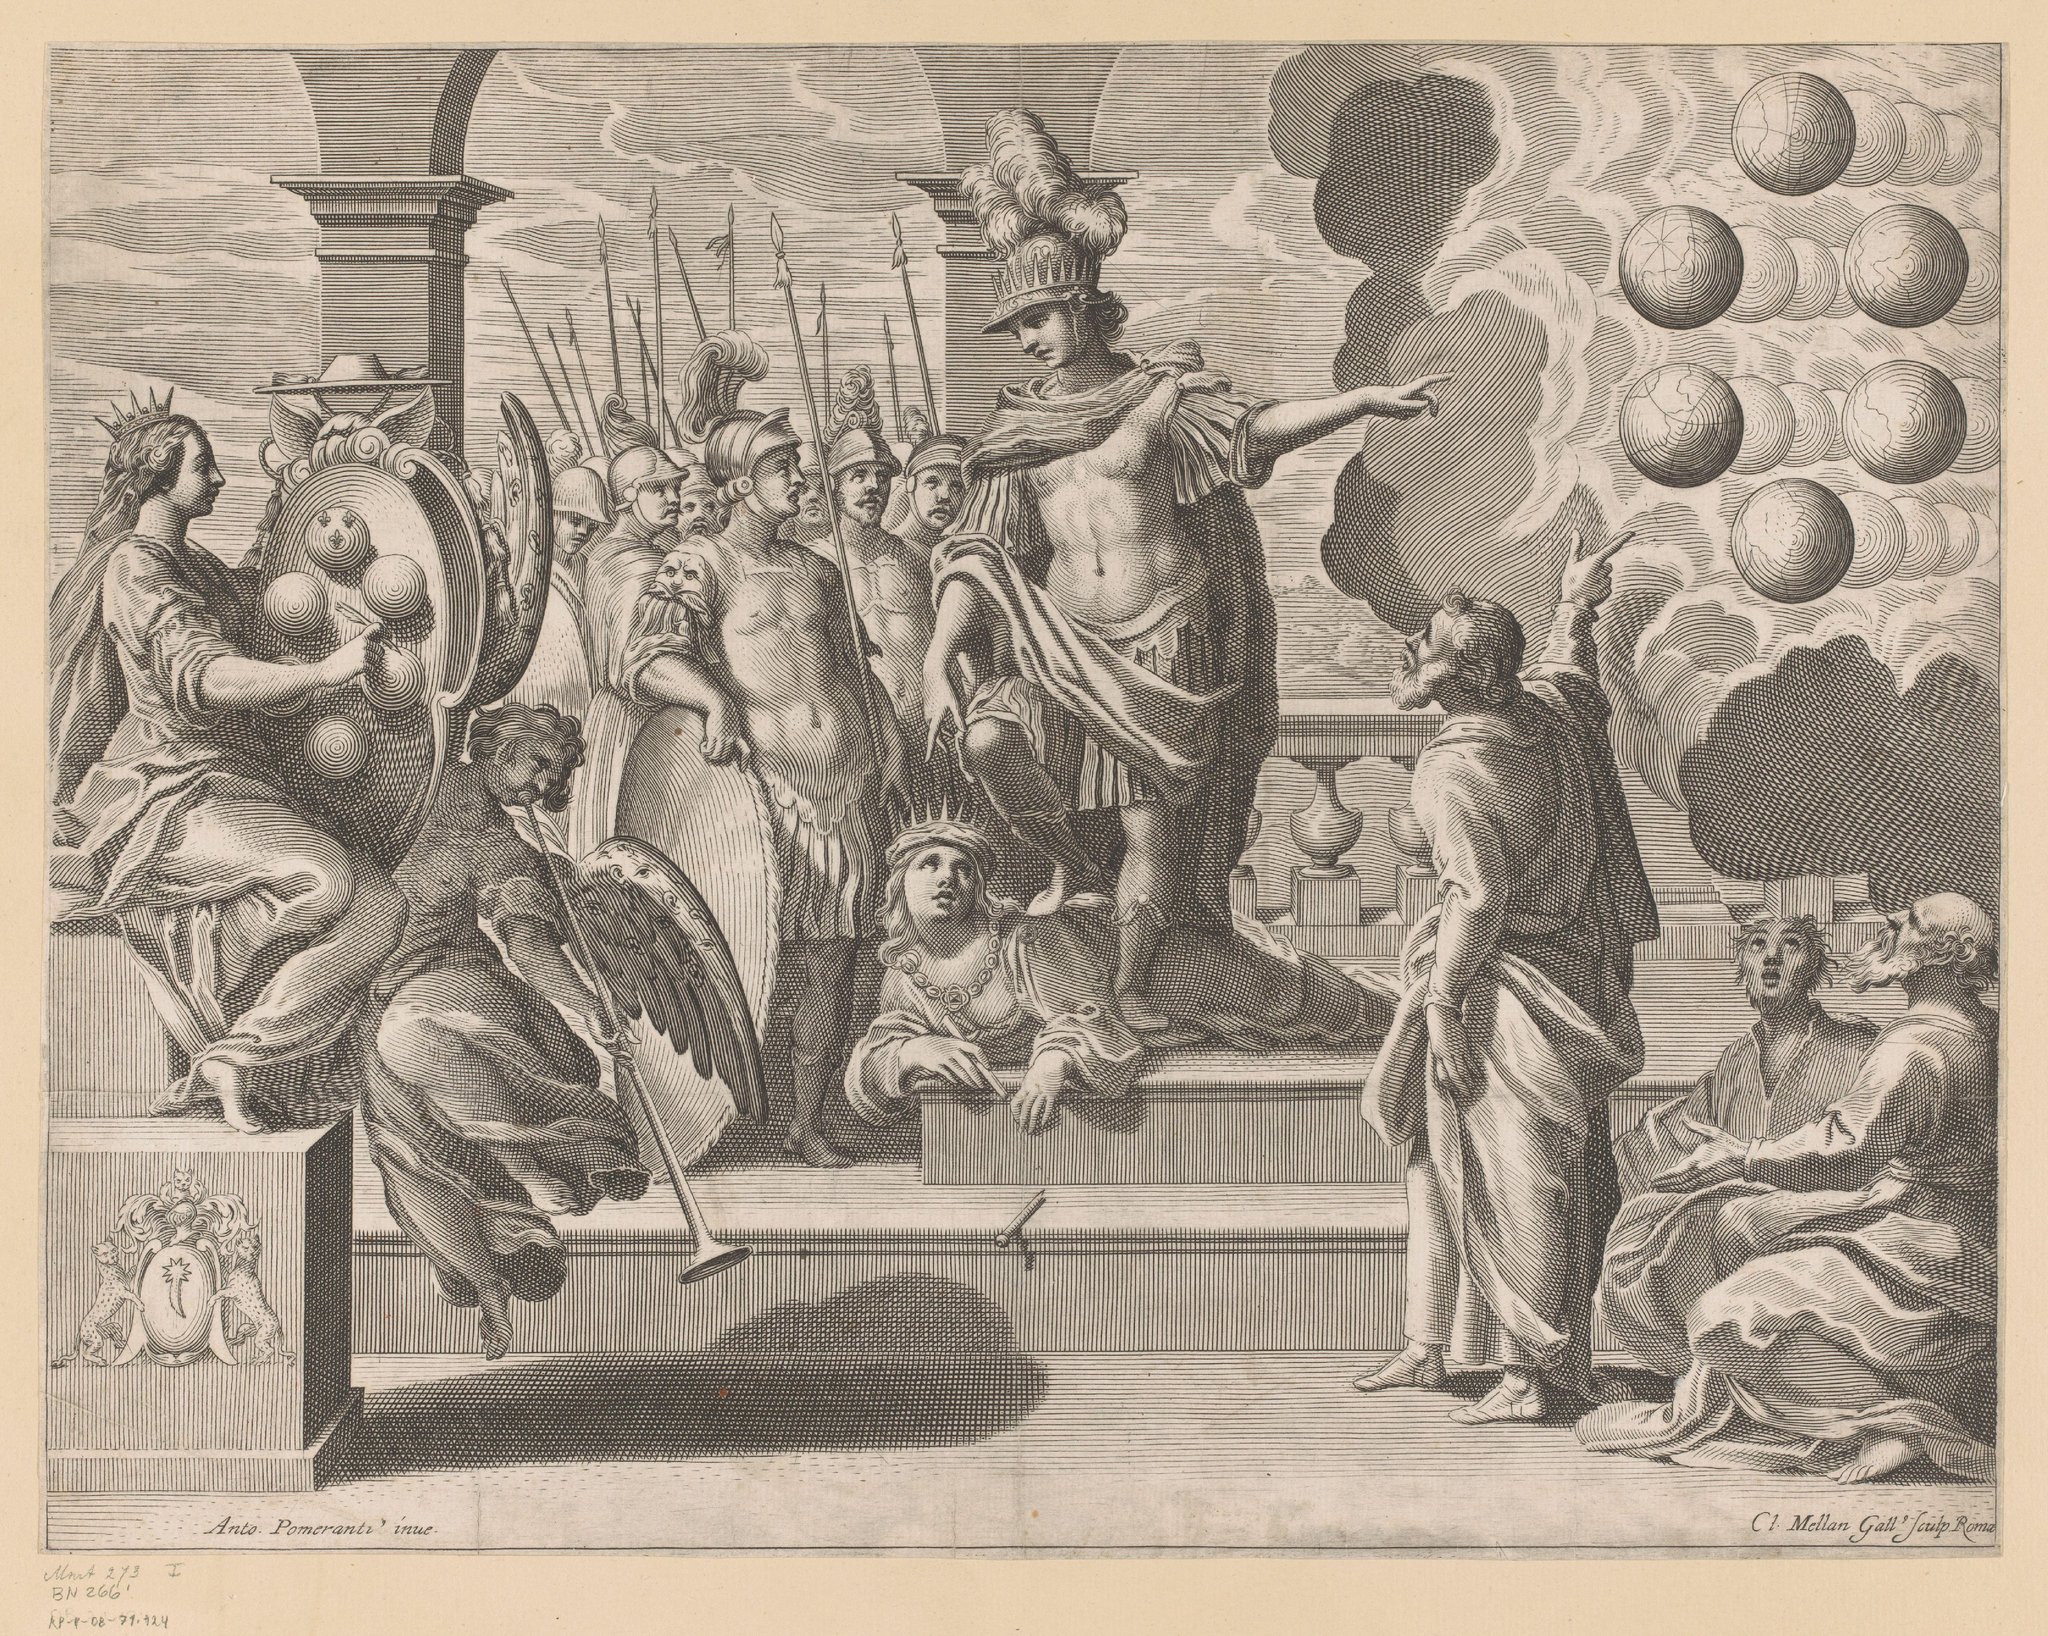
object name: print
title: Allegorie met soldaten en het wapenschild van de Medicis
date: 1624-1636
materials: paper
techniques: engraving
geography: rome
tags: the soldier; the soldier's life, armorial bearing, heraldry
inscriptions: collector's mark: Lugt 240